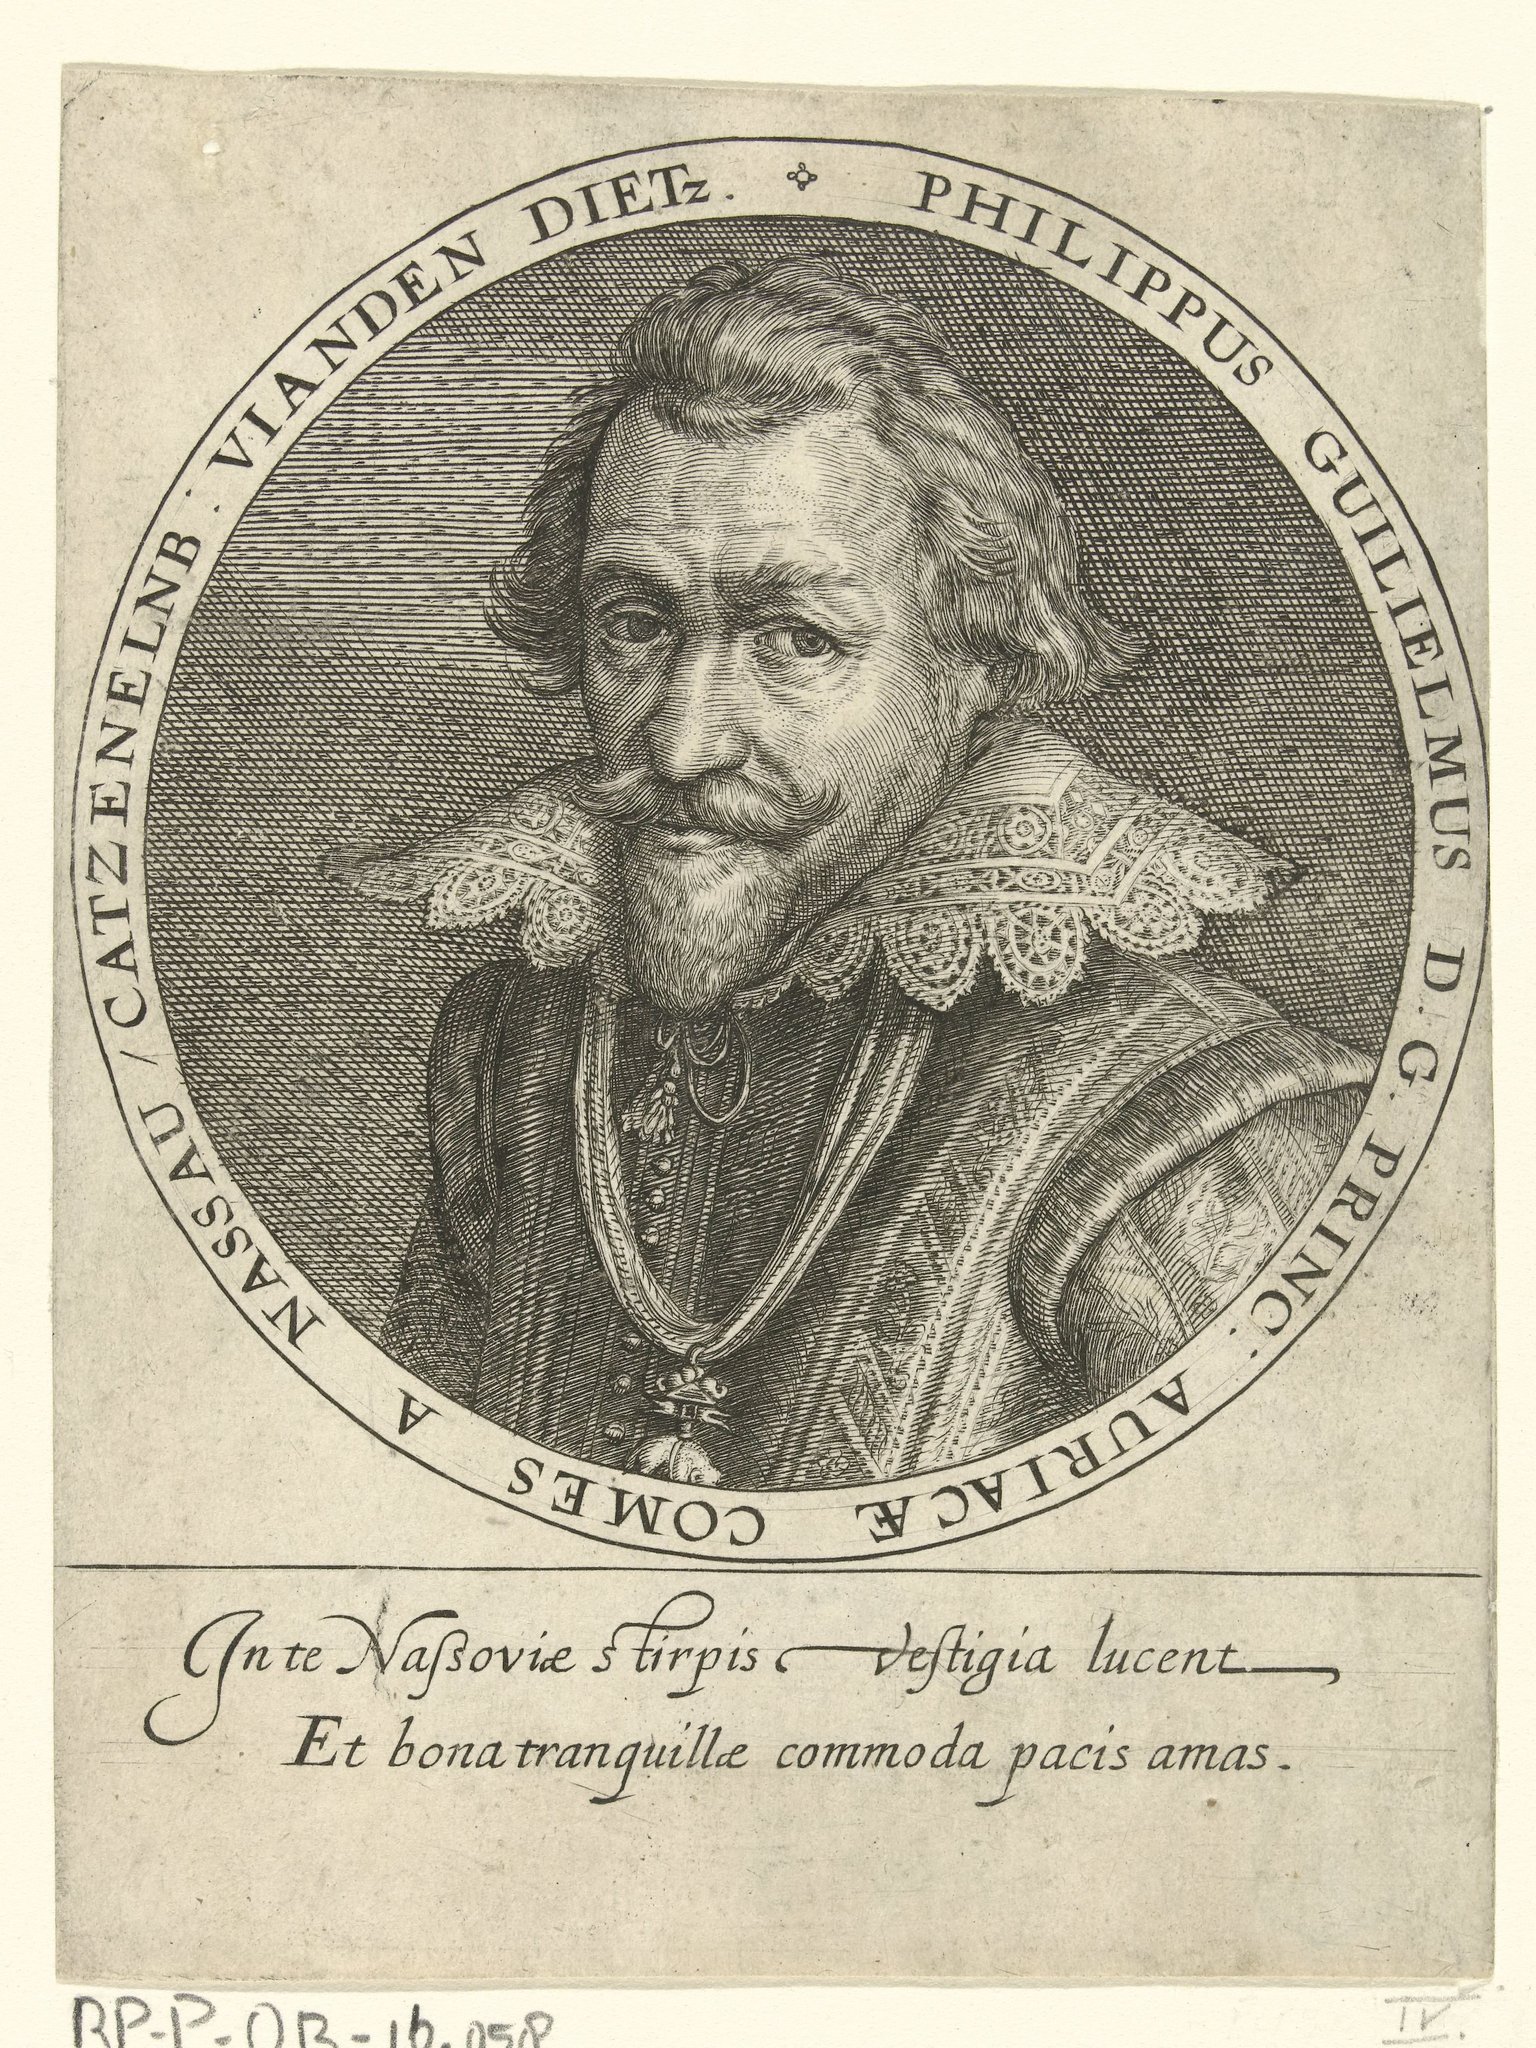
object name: print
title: Portret van Filips Willem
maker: crispijn van de passe (i)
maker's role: draughtsman, print maker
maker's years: 1564-1637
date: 1615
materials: paper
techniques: engraving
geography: utrecht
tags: buren, bruges, filips willem (prins van oranje), knighthood order of the golden fleece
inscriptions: collector's mark: Lugt 963, collector's mark: Lugt 2228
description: Portret van Filips Willem, prins van Oranje, graaf van Nassau. Hij draagt een lint met de Orde van het Gulden Vlies. In het randschrift van de omlijsting de naam en functie van de geportretteerde in het Latijn. In de marge een tweeregelig lofdicht in het Latijn.